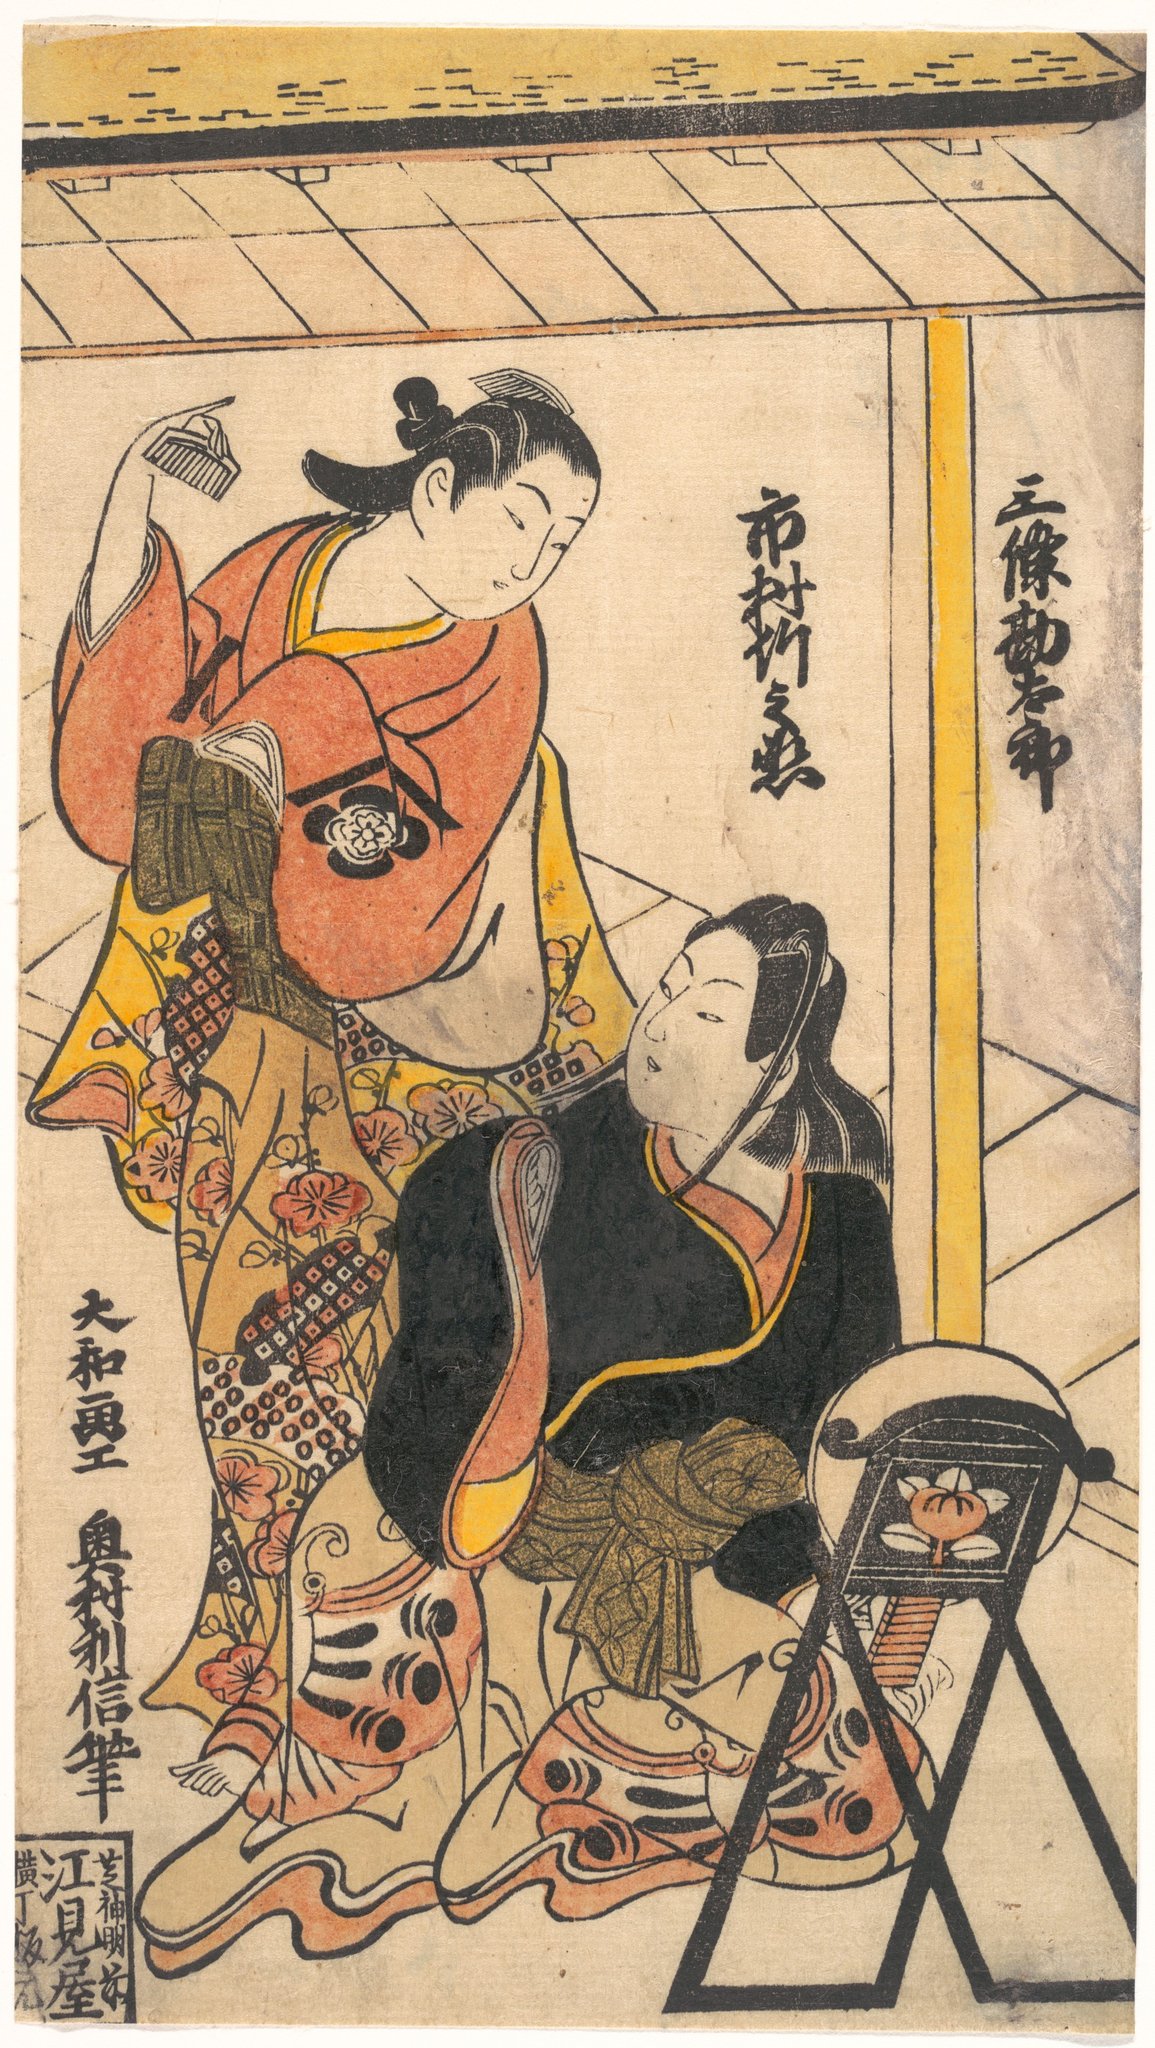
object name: print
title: Portrait of Ichimura Takenojō and Sanjō Kantarō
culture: japanese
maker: okumura toshinobu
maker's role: artist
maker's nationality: japanese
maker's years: 1717-1750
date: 1793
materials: ink, paper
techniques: hand coloring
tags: men,women,actors,mirrors